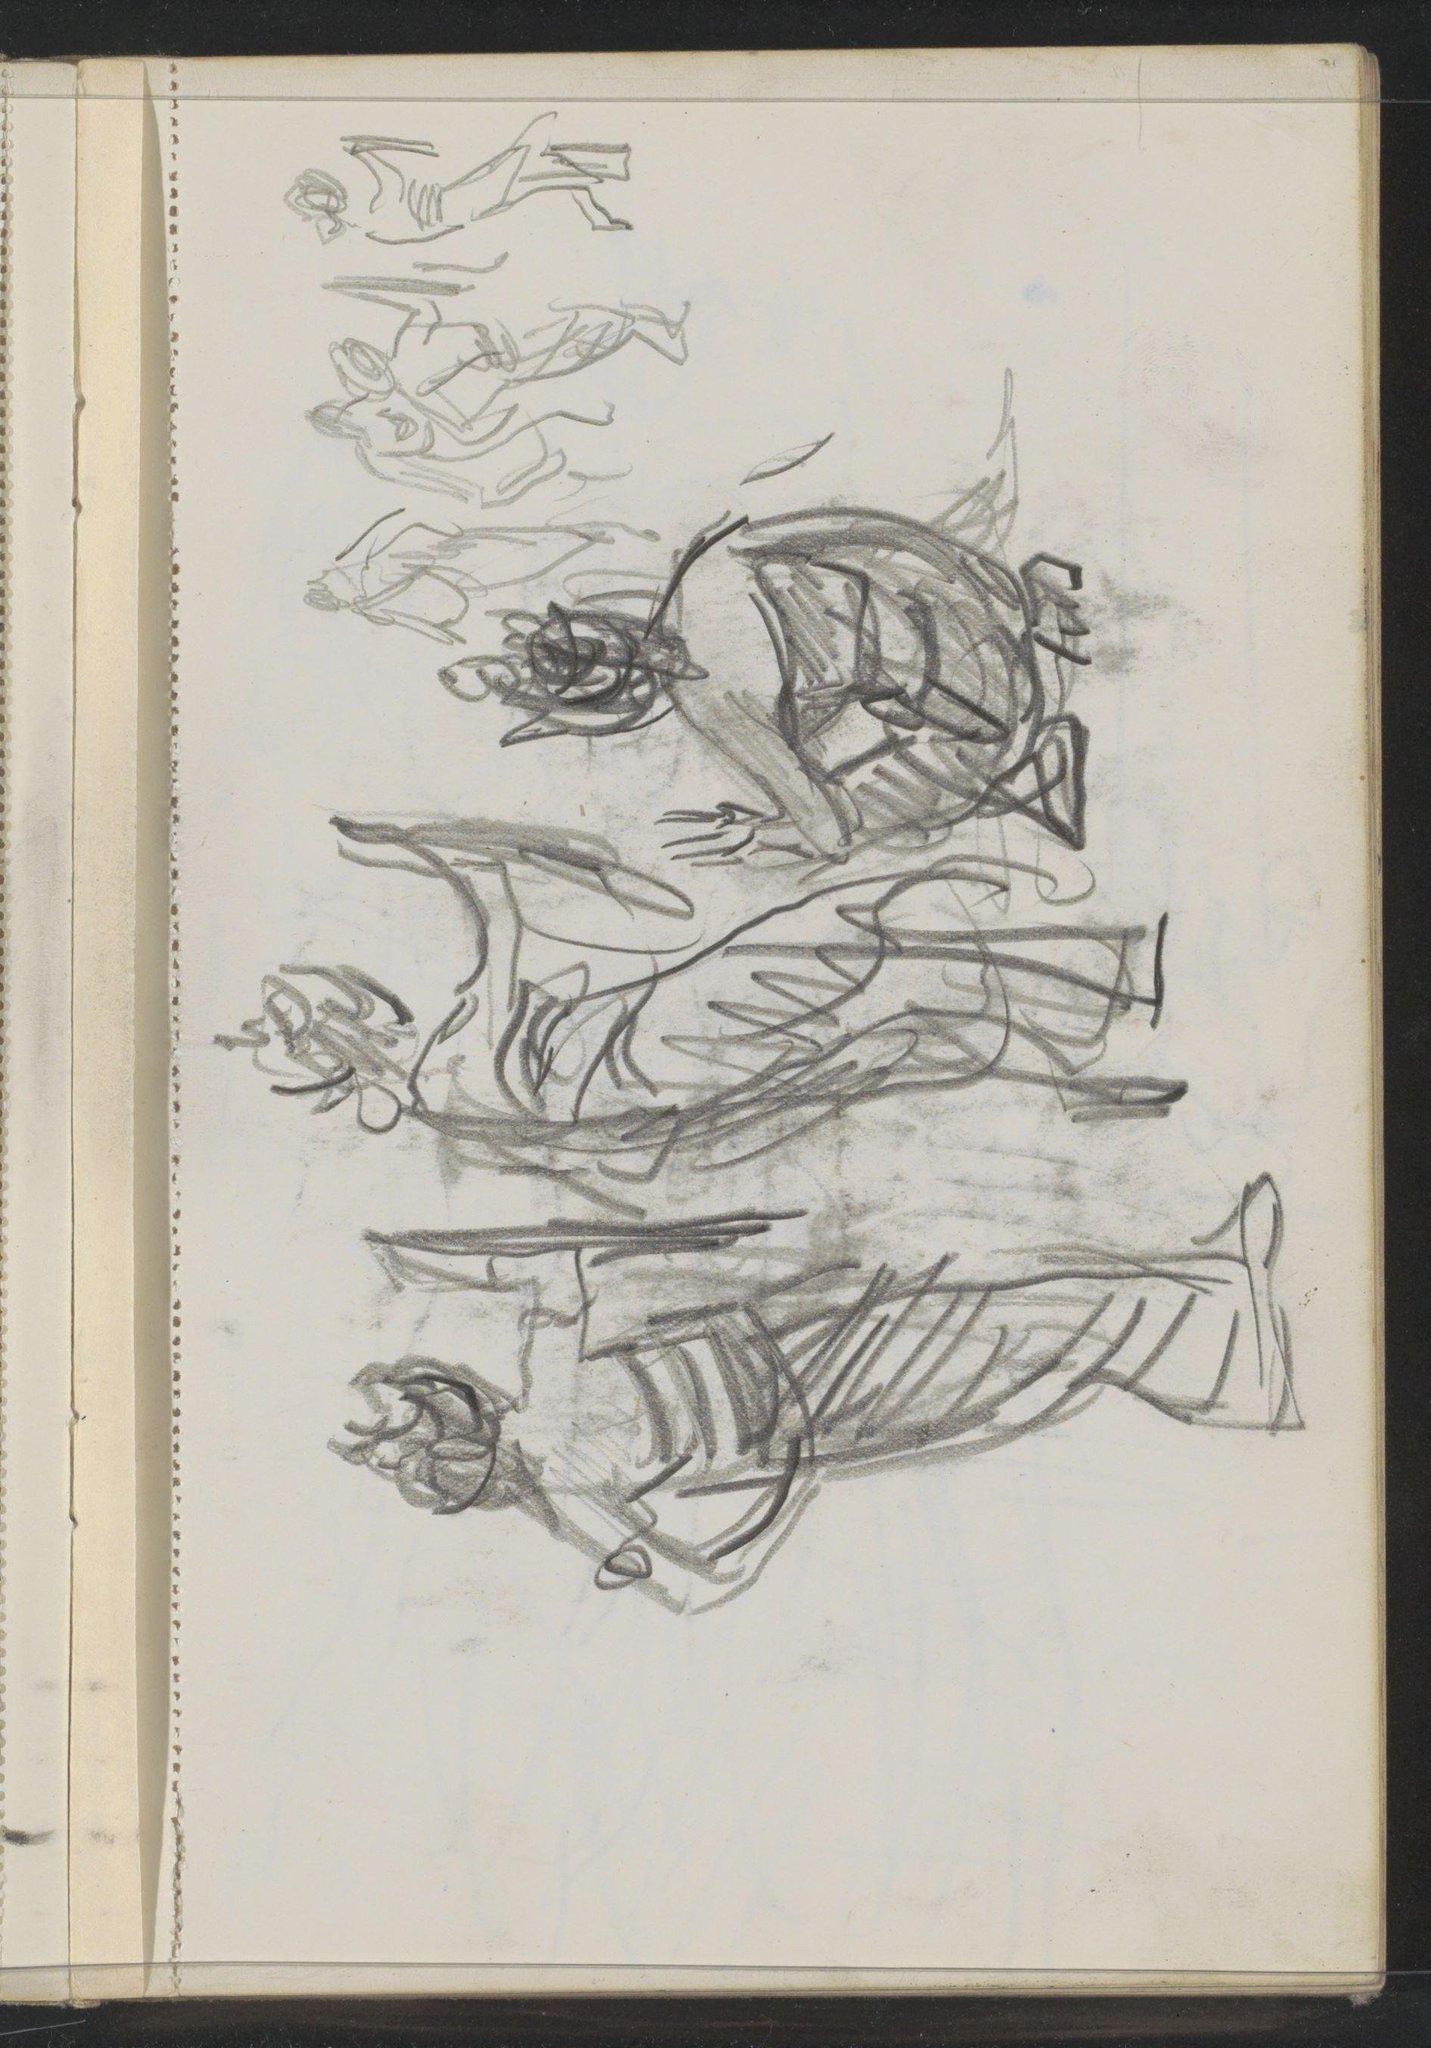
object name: sketchbook leaf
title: Twee groepen dansende serimpies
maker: marius bauer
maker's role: draughtsman, print maker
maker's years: 1867-1932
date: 1925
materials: paper, pencil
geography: indonesia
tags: folk costume, regional costume, group of women (folk dancing)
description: Pagina 21 uit een schetsboek met 74 bladen.